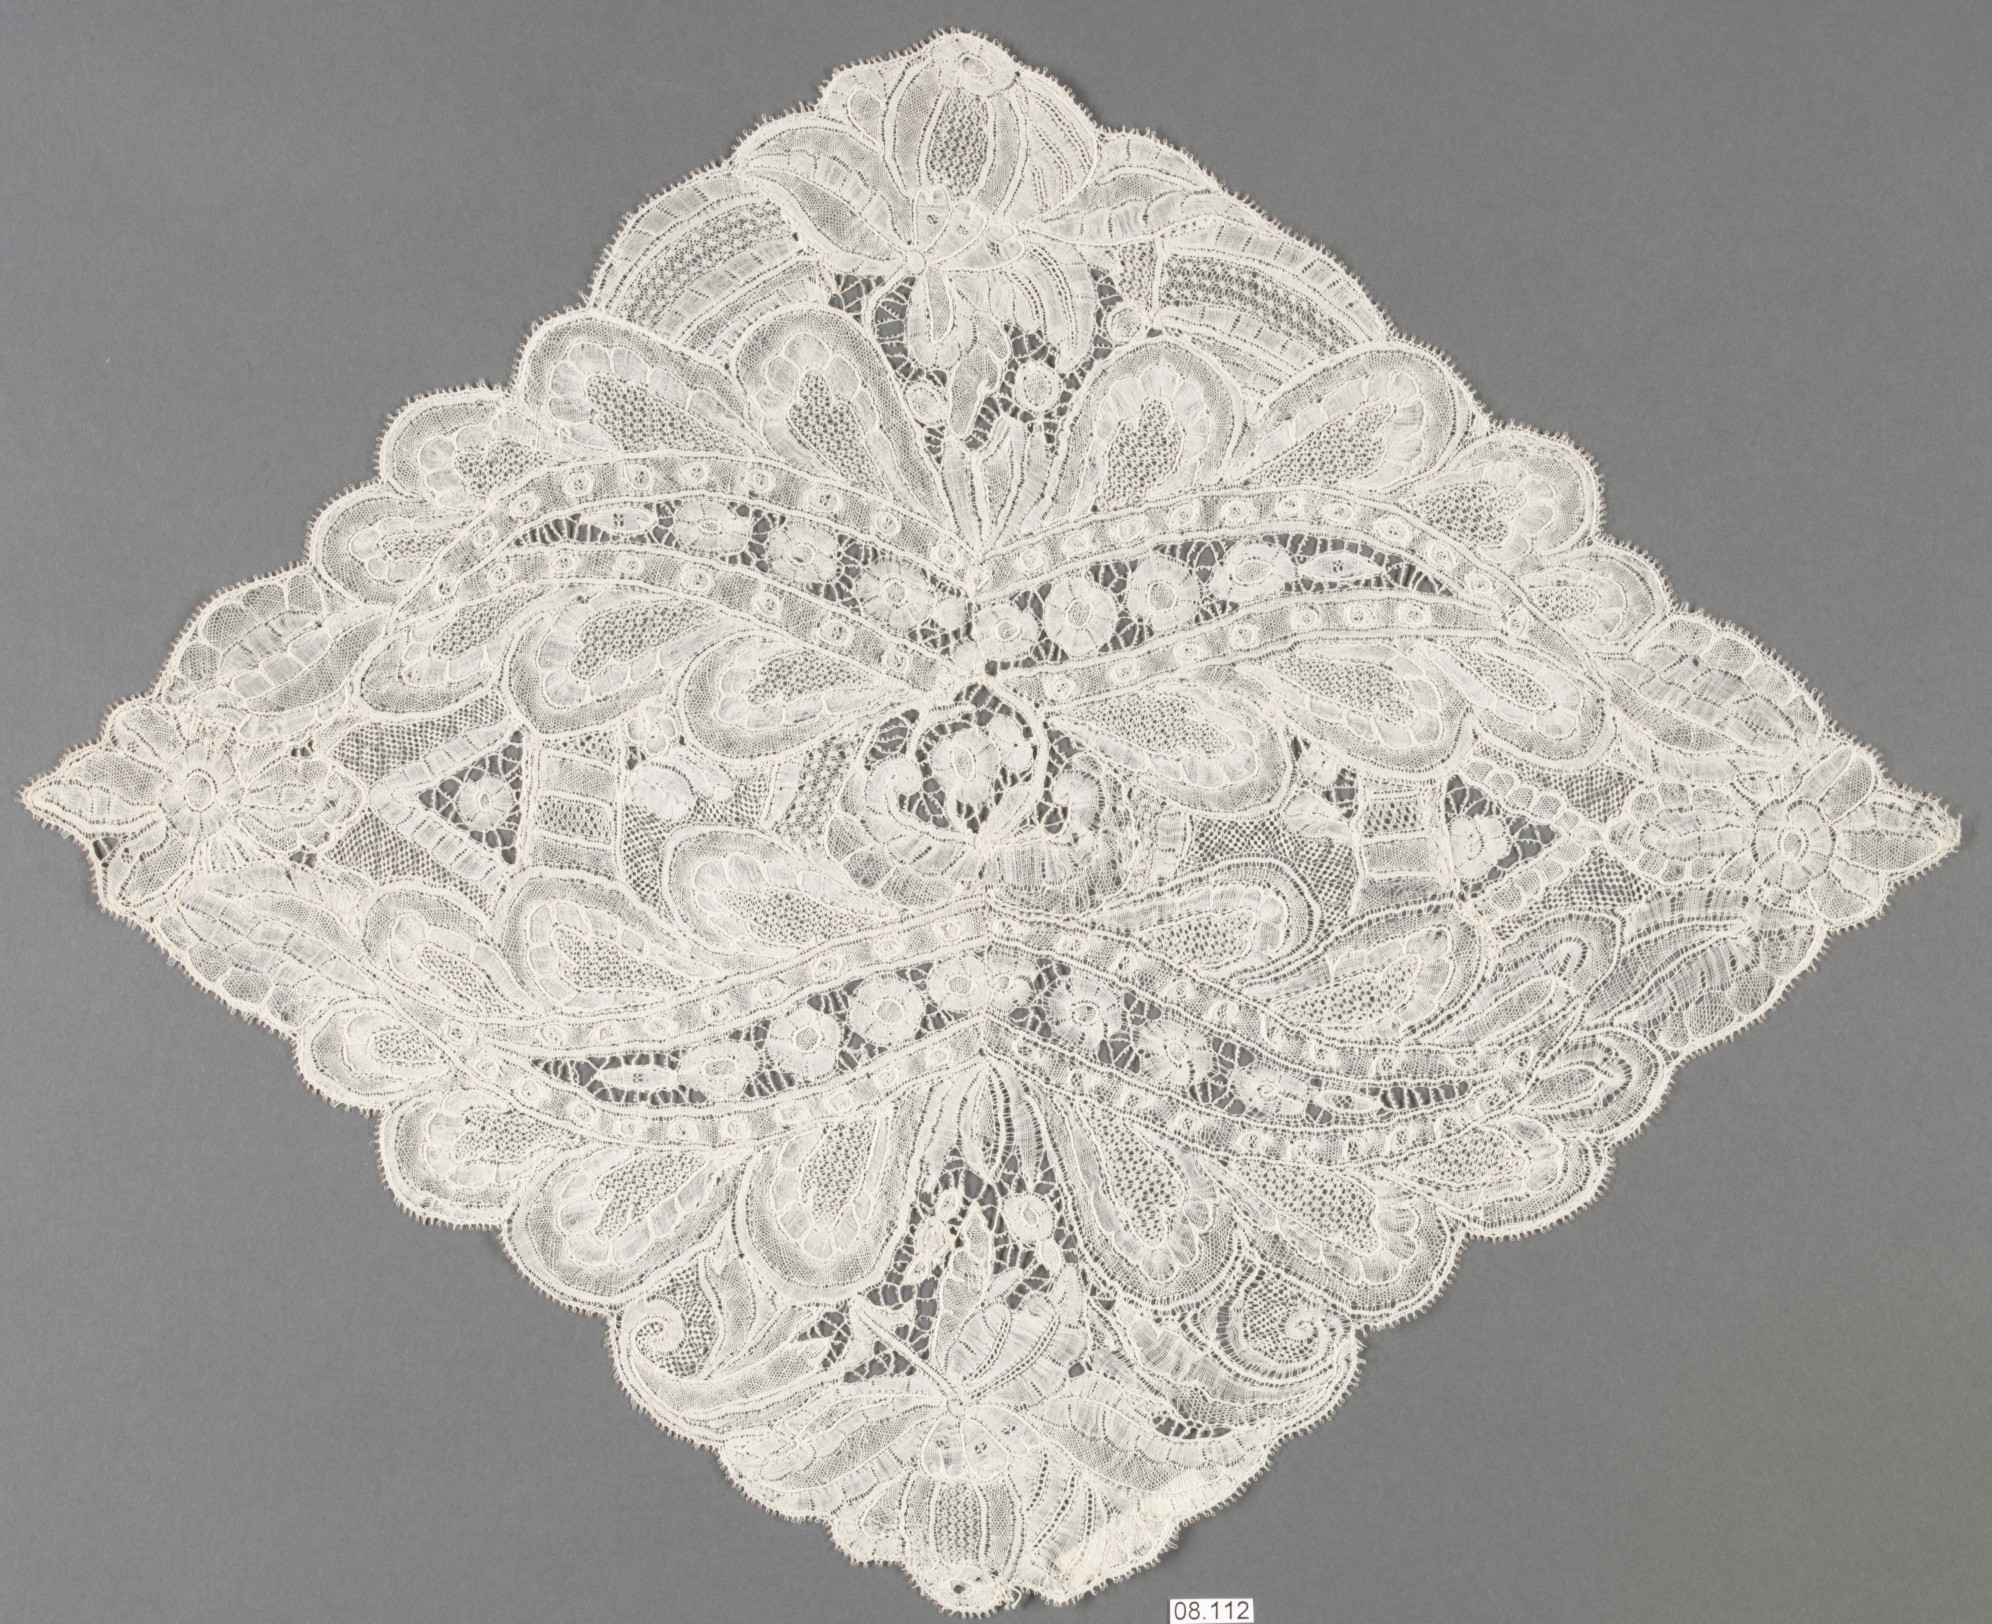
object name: square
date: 1701-1733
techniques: lace